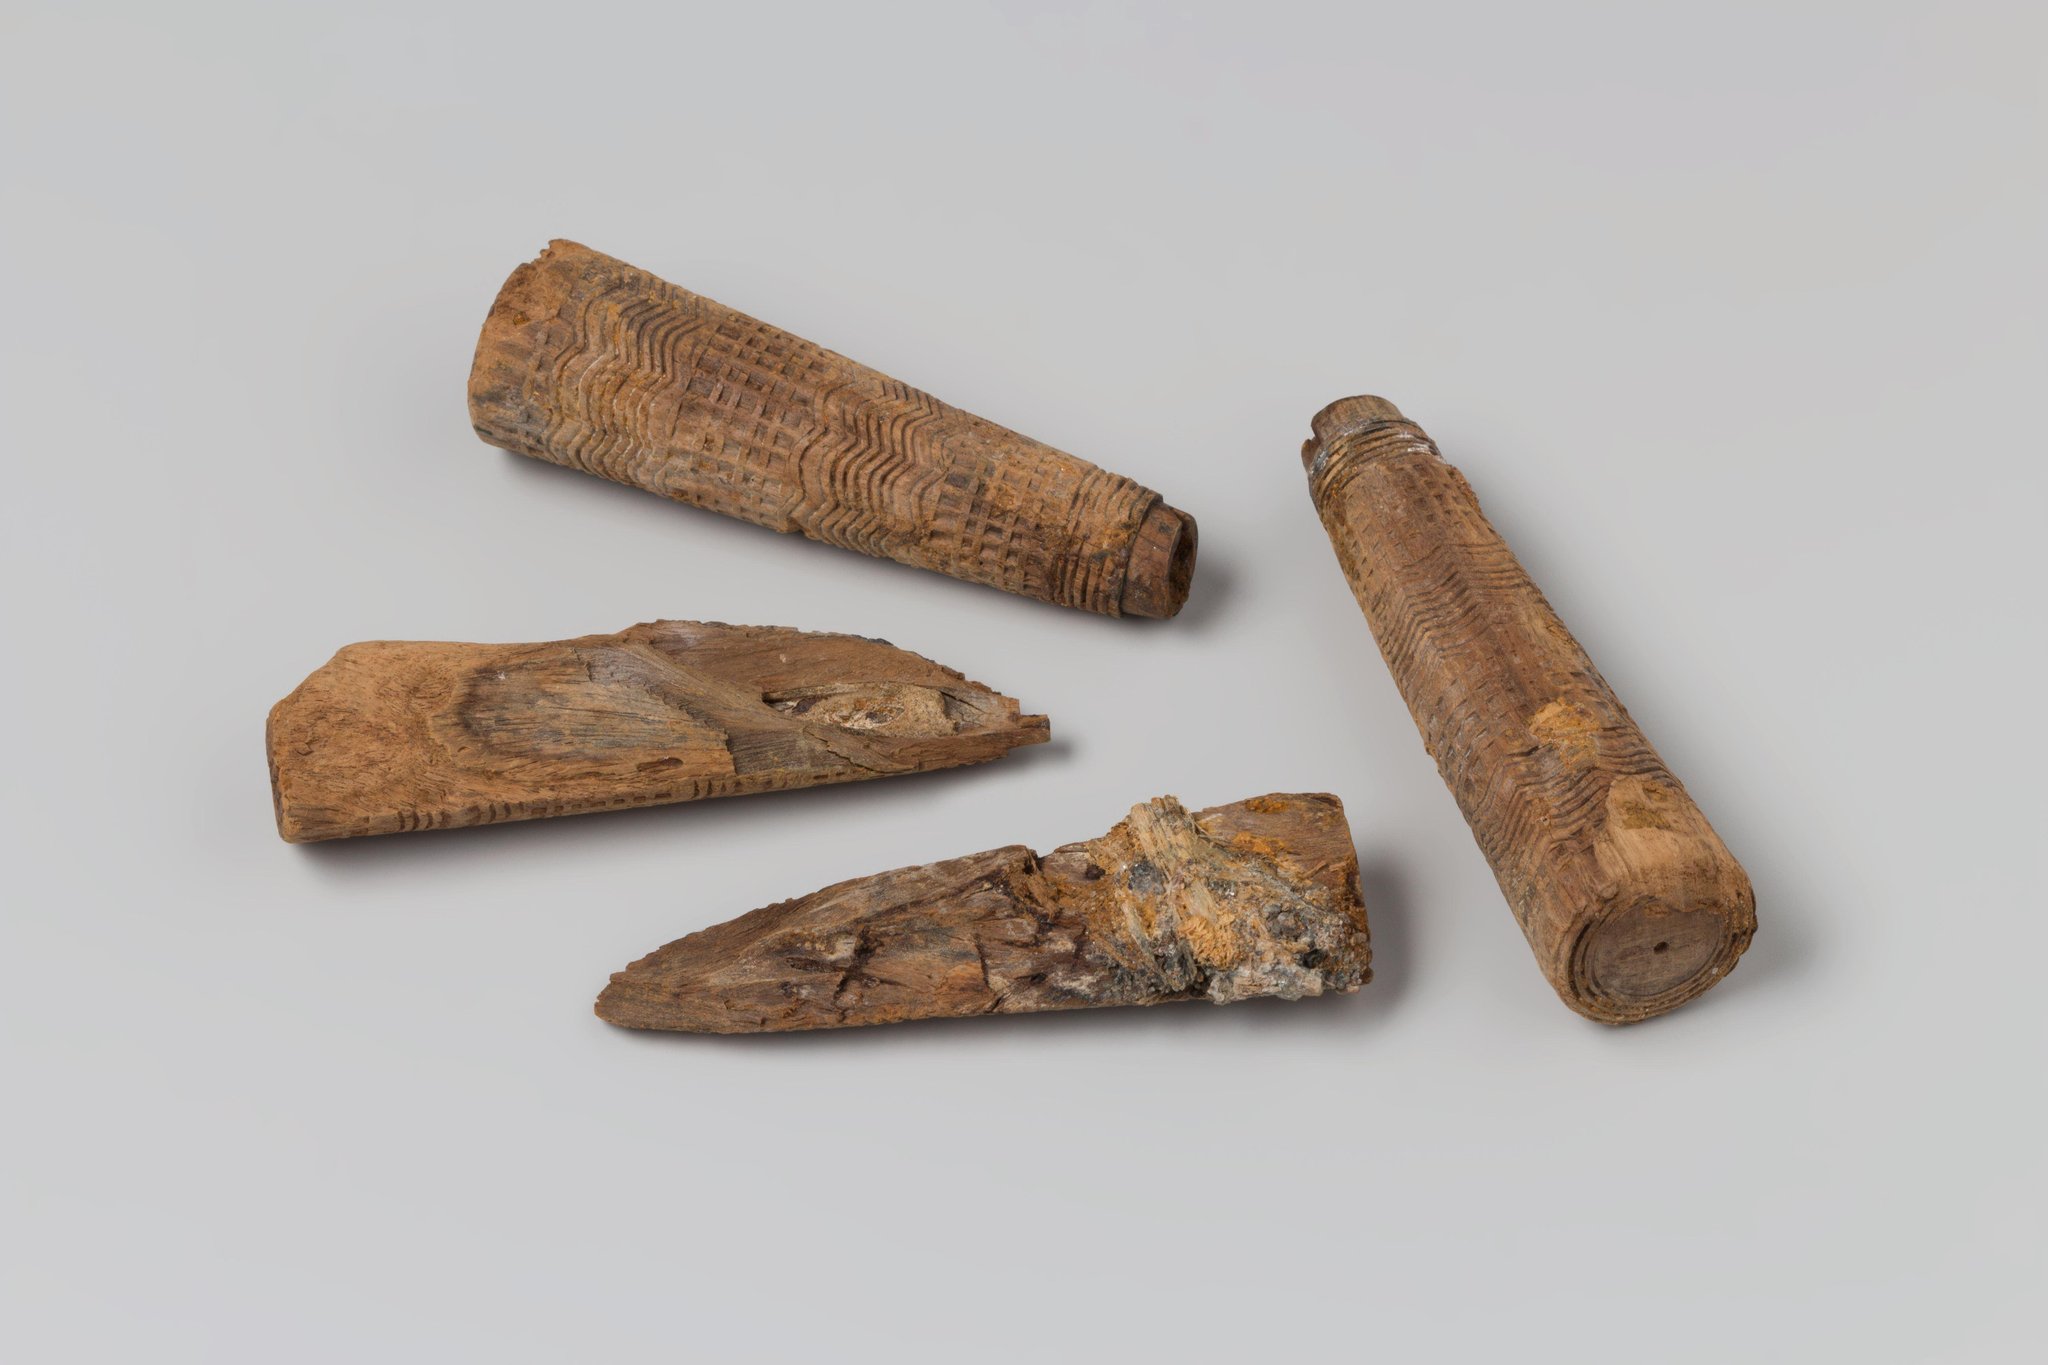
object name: knife handle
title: Messenheften uit het wrak van de Oost-Indiëvaarder Hollandia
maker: Anonymous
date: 1700-1743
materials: wood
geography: netherlands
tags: verenigde oostindische compagnie, hollandia (schip), annet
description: Knife, handle, cylindrical: tapering; id. NG 1979-403H.